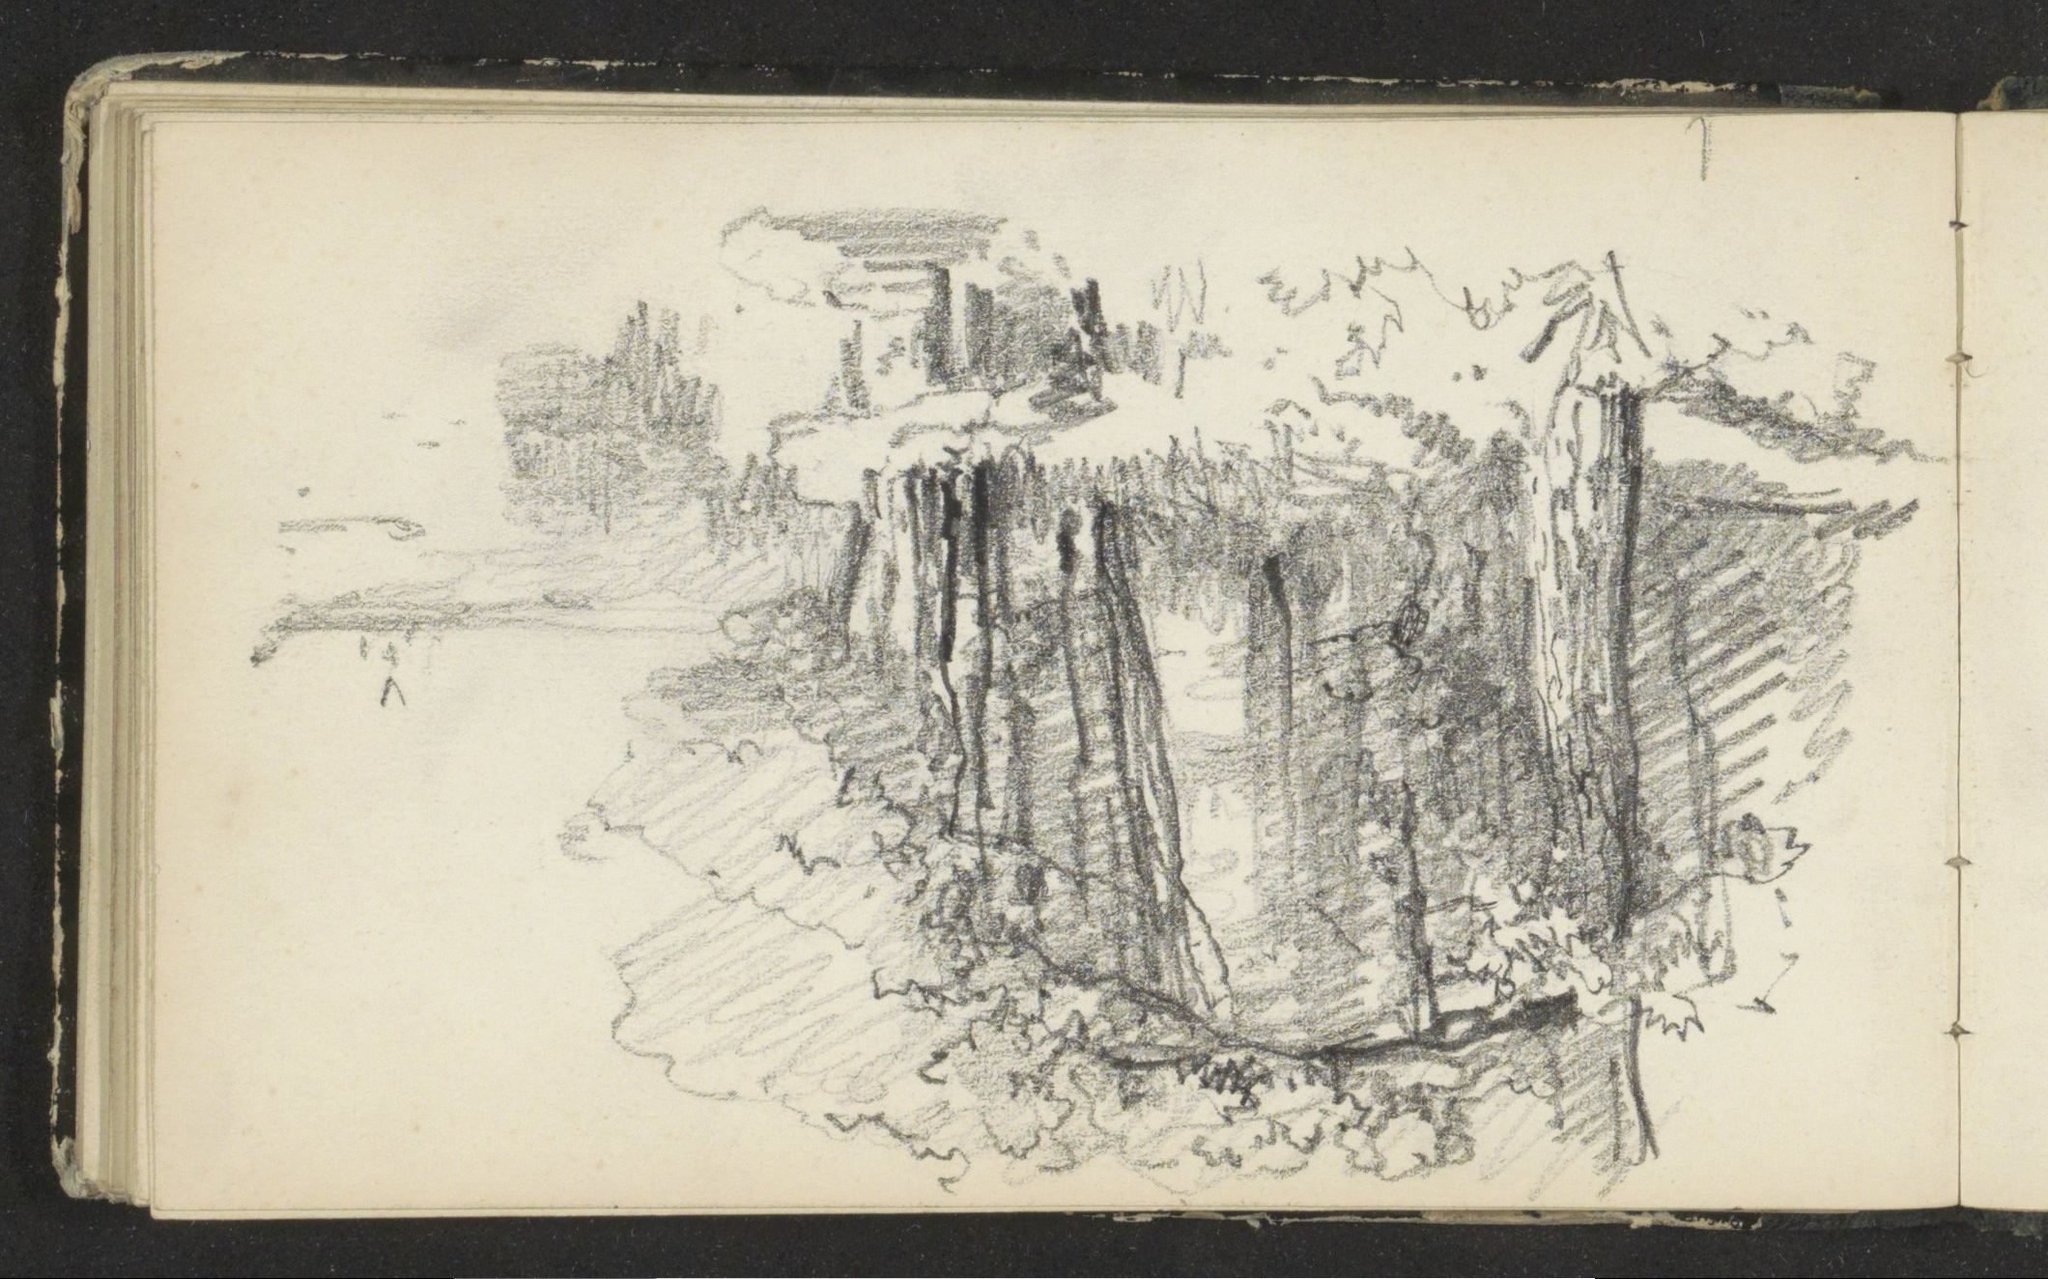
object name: sketchbook leaf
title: Bomen langs een rivier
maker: maria vos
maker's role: draughtsman, painter, print maker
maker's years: 1824-1906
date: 1834-1906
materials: paper, pencil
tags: trees, river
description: Blad 37 verso uit een schetsboek met 46 bladen.